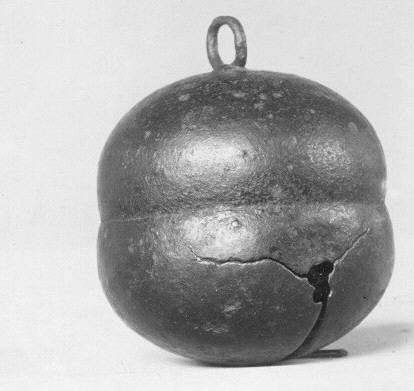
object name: maling horse bell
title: Maling (Horse Bell)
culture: japanese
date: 1801-1900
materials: metal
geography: japan